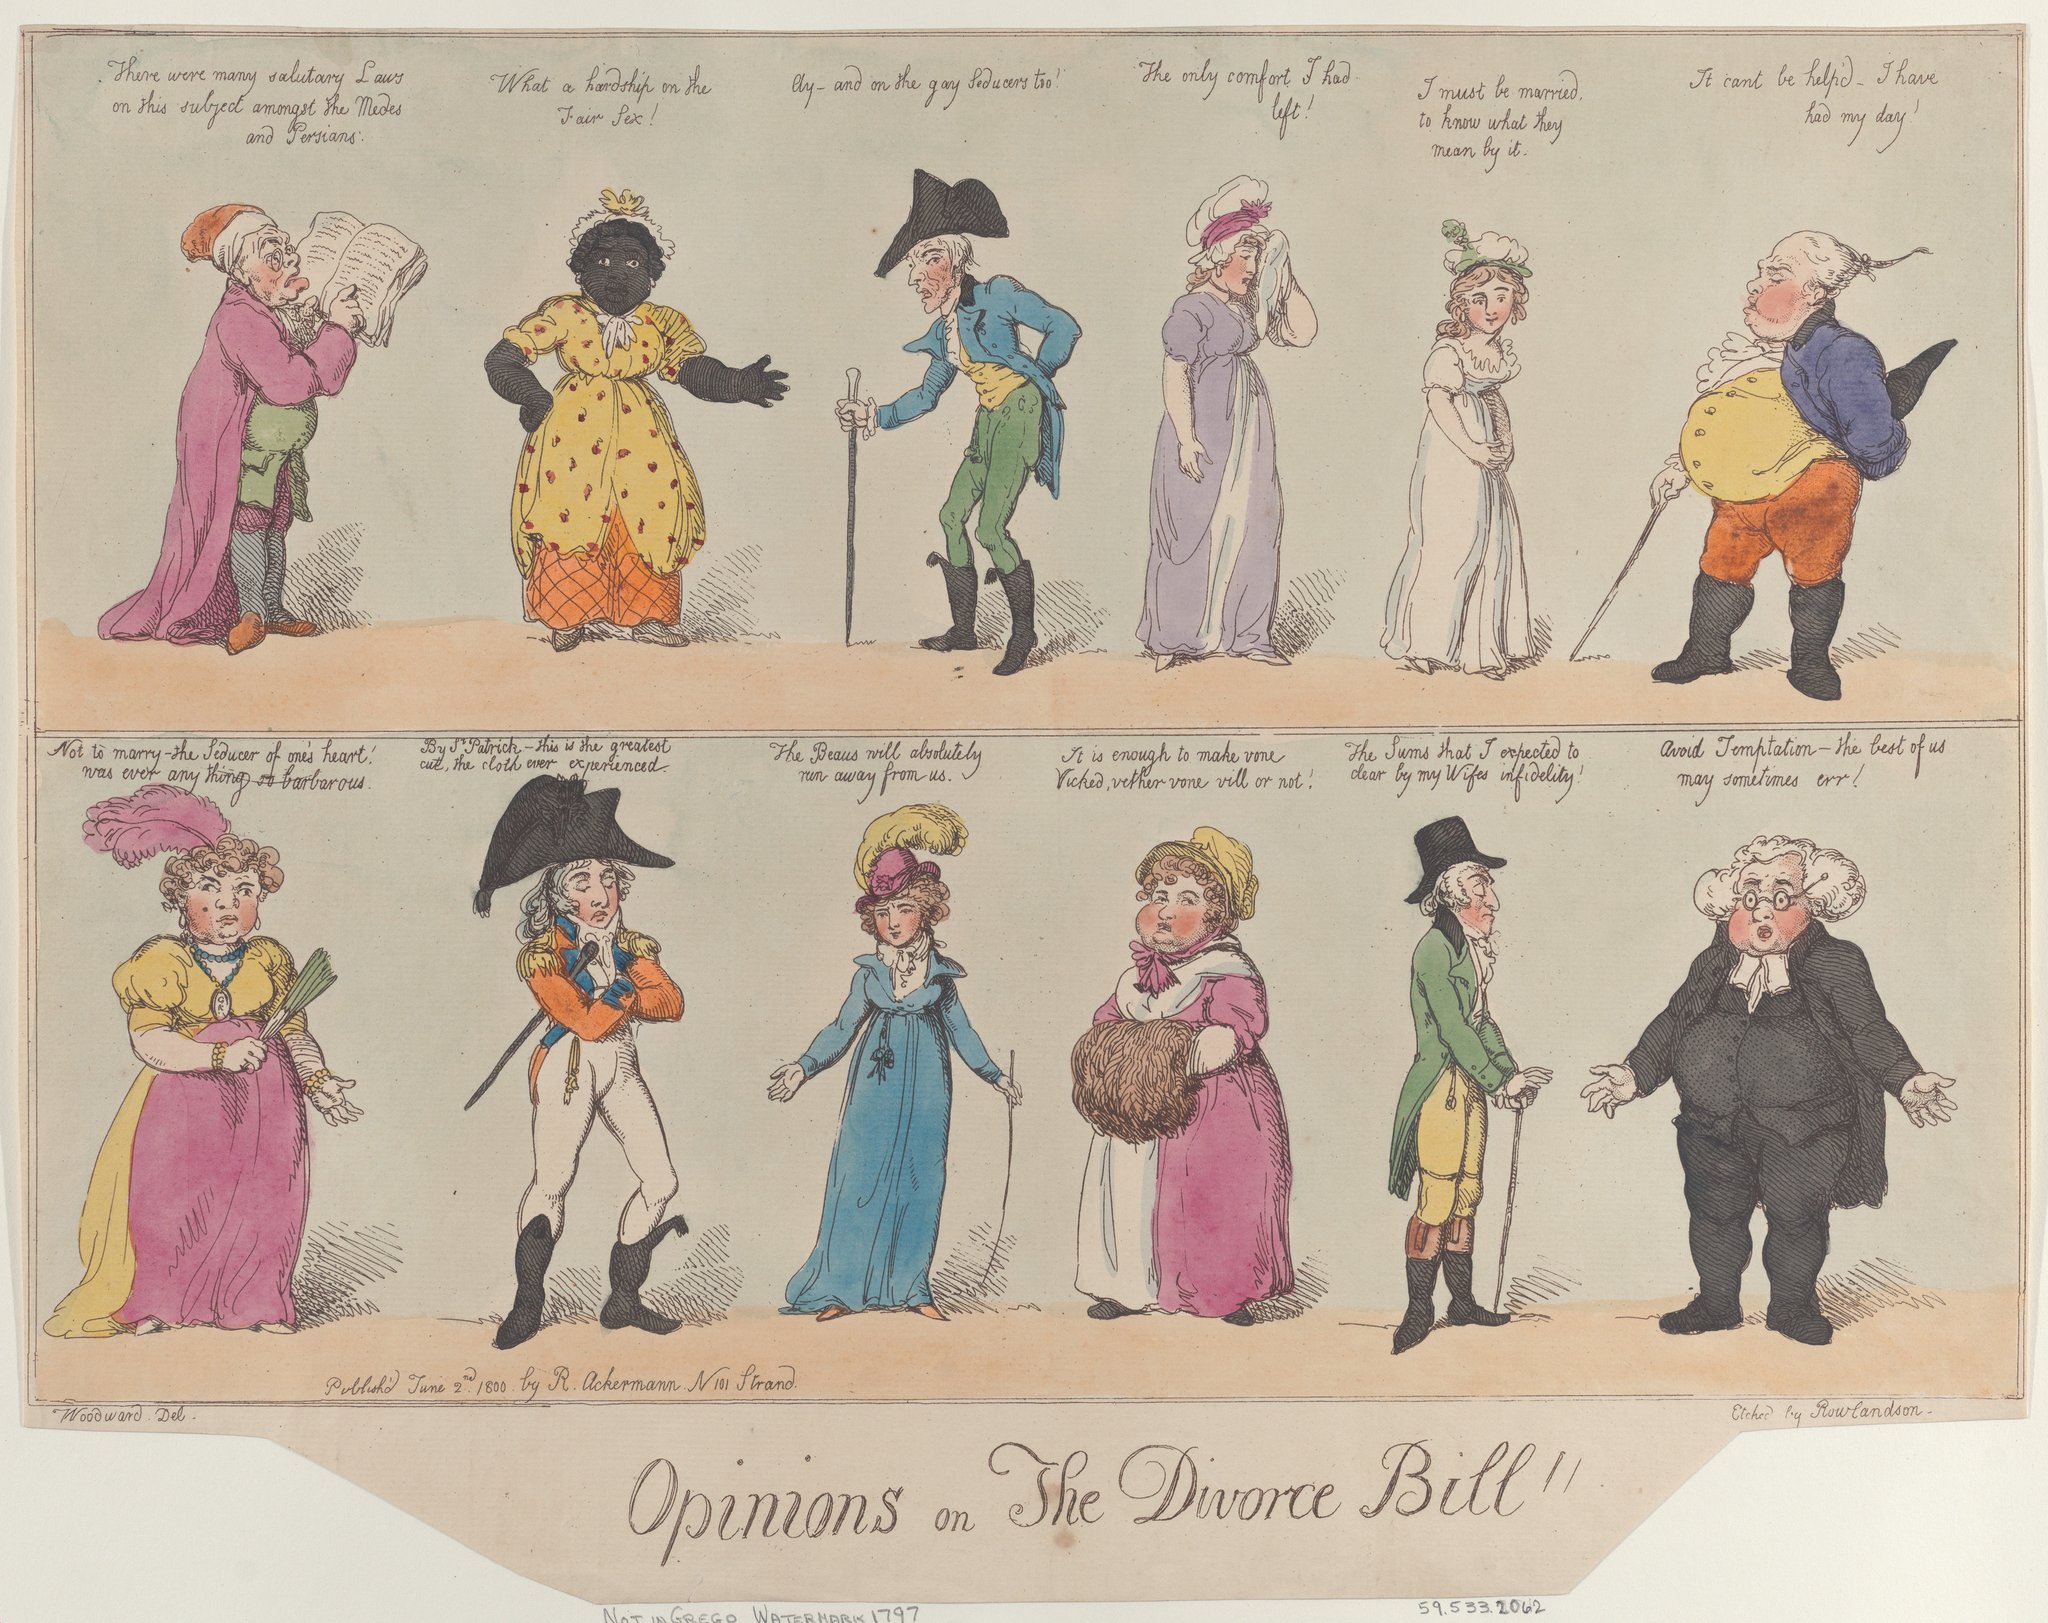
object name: print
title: Opinions on The Divorce Bill!!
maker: thomas rowlandson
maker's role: artist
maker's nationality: british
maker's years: 1757-1827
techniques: etching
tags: satire,men,women